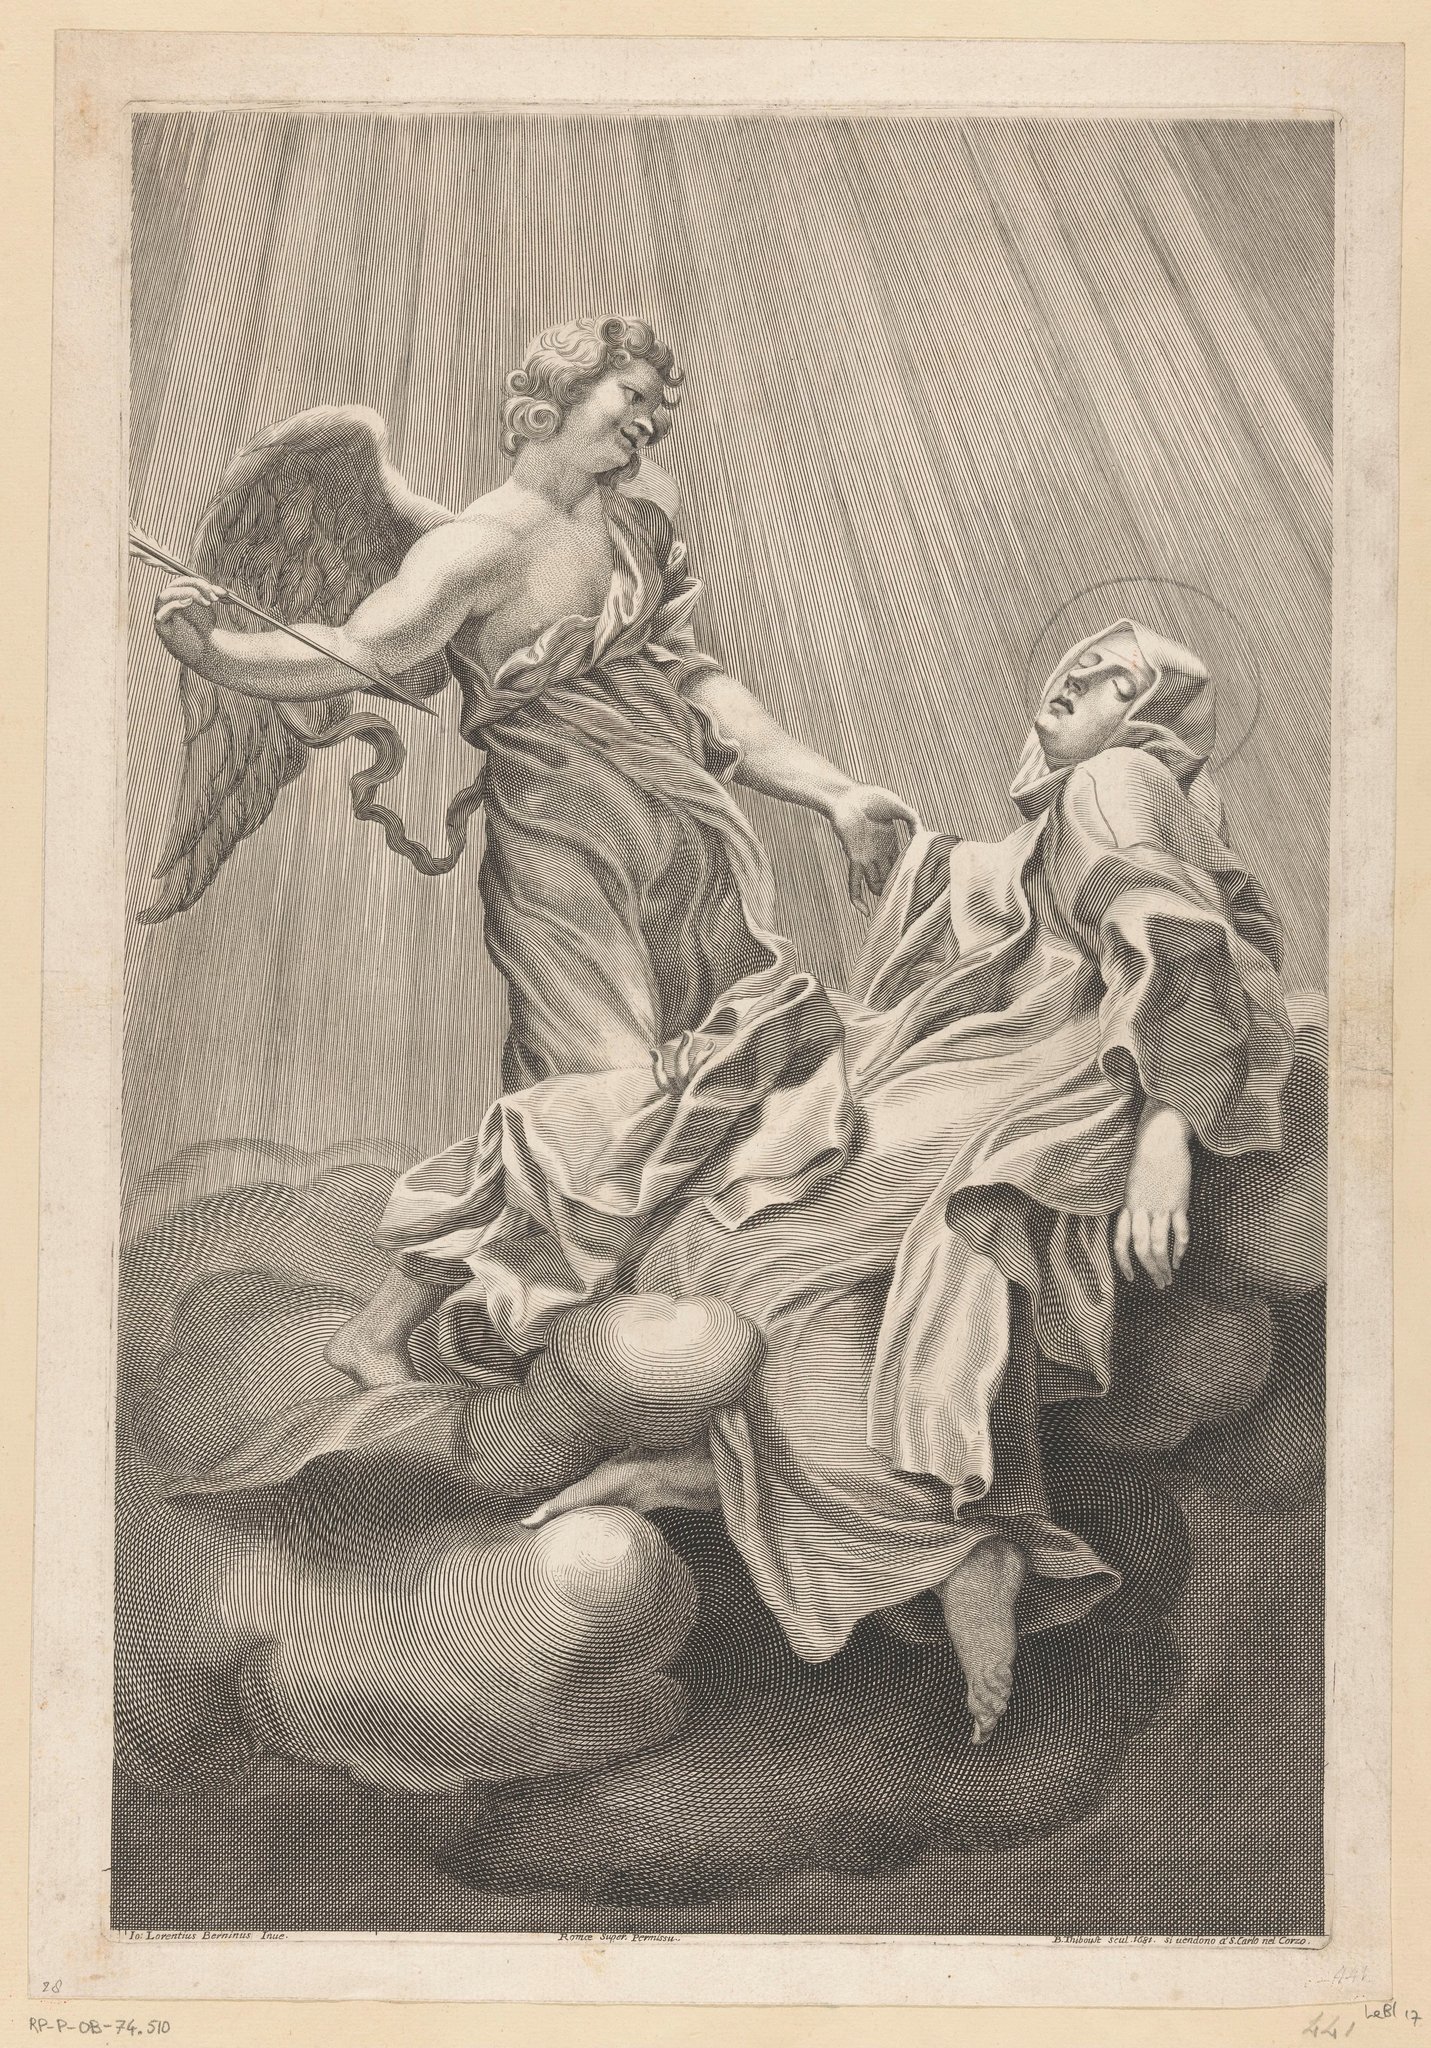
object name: print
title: Extase van Teresa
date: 1681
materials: paper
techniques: engraving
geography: vatican city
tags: personal devotion of st. theresa - female saint meditating, in ecstasy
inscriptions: collector's mark: Lugt 240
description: Het beeld door Bernini bevindt zich in de Santa Maria della Vittoria in Rome. Het werd tussen 1647 en 1652 vervaardigd.